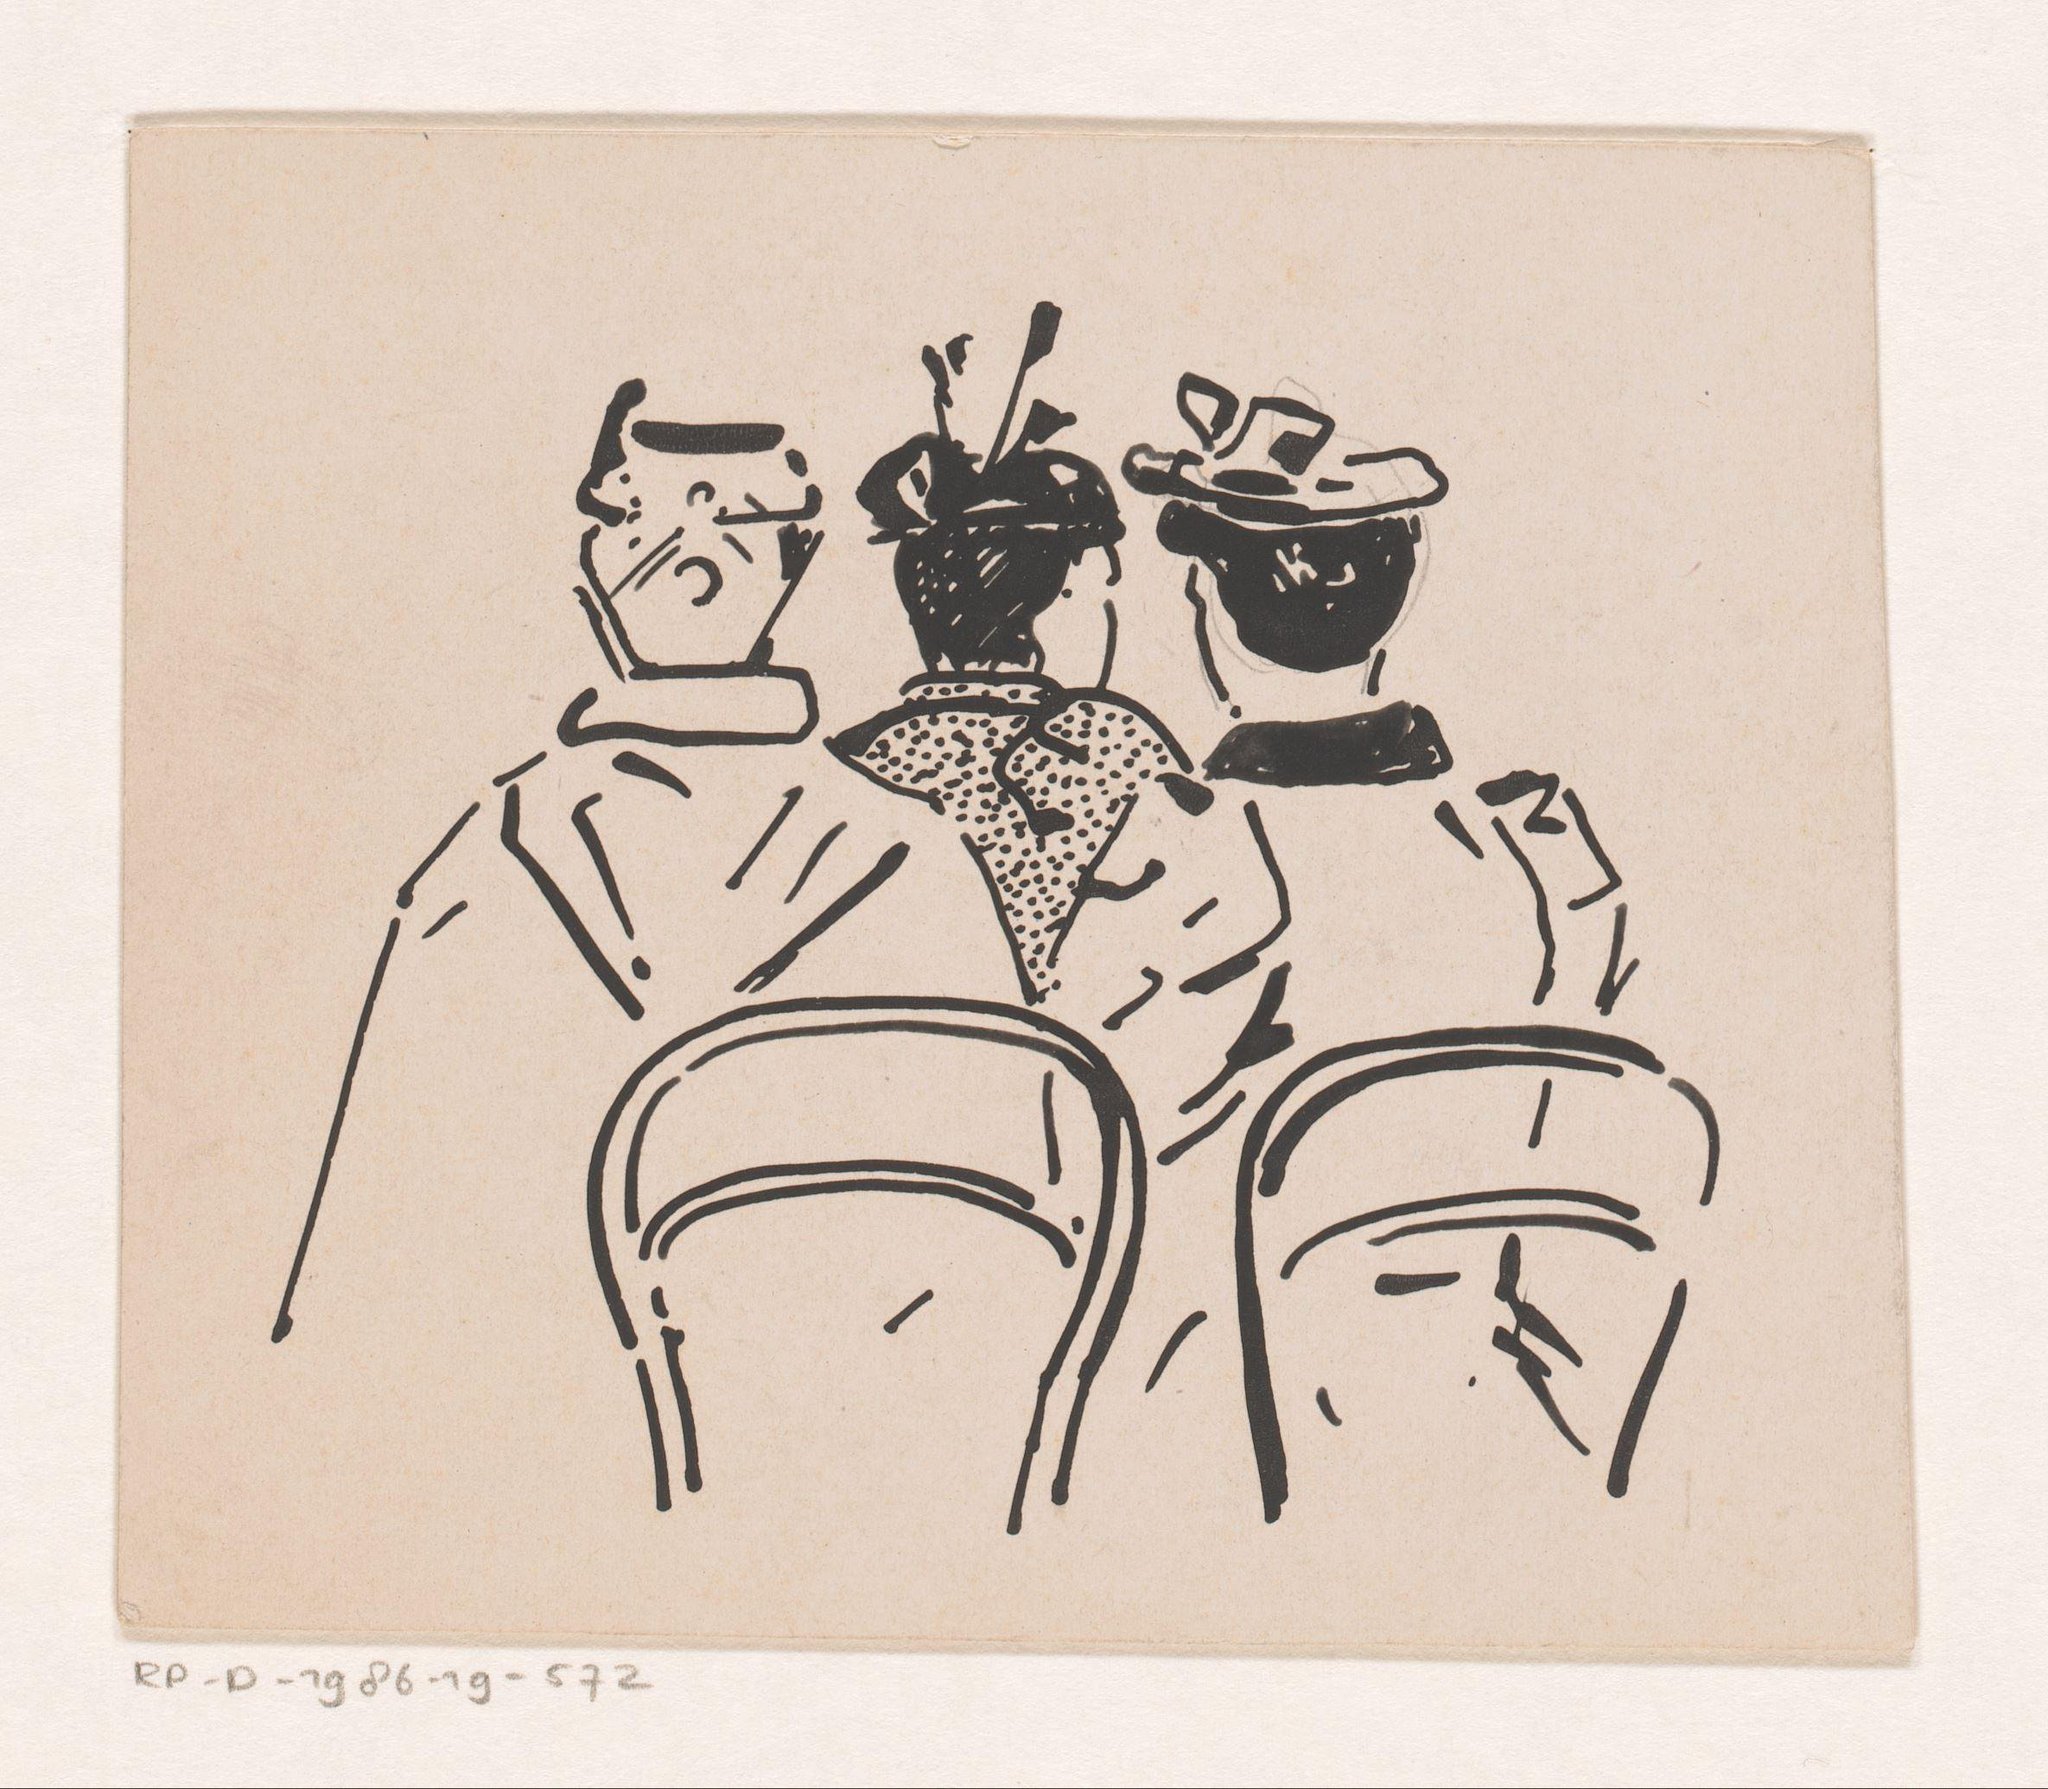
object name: drawing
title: Drie zittende vrouwen op een rij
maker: reinier willem petrus de vries (1874-1953)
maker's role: draughtsman, print maker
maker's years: 1874-1953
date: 1884-1952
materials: ink, paper, pencil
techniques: brush, pen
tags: sitting figure - aa - female human figure (+ back view), head-gear: hat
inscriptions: collector's mark: ‘R:MVS.’